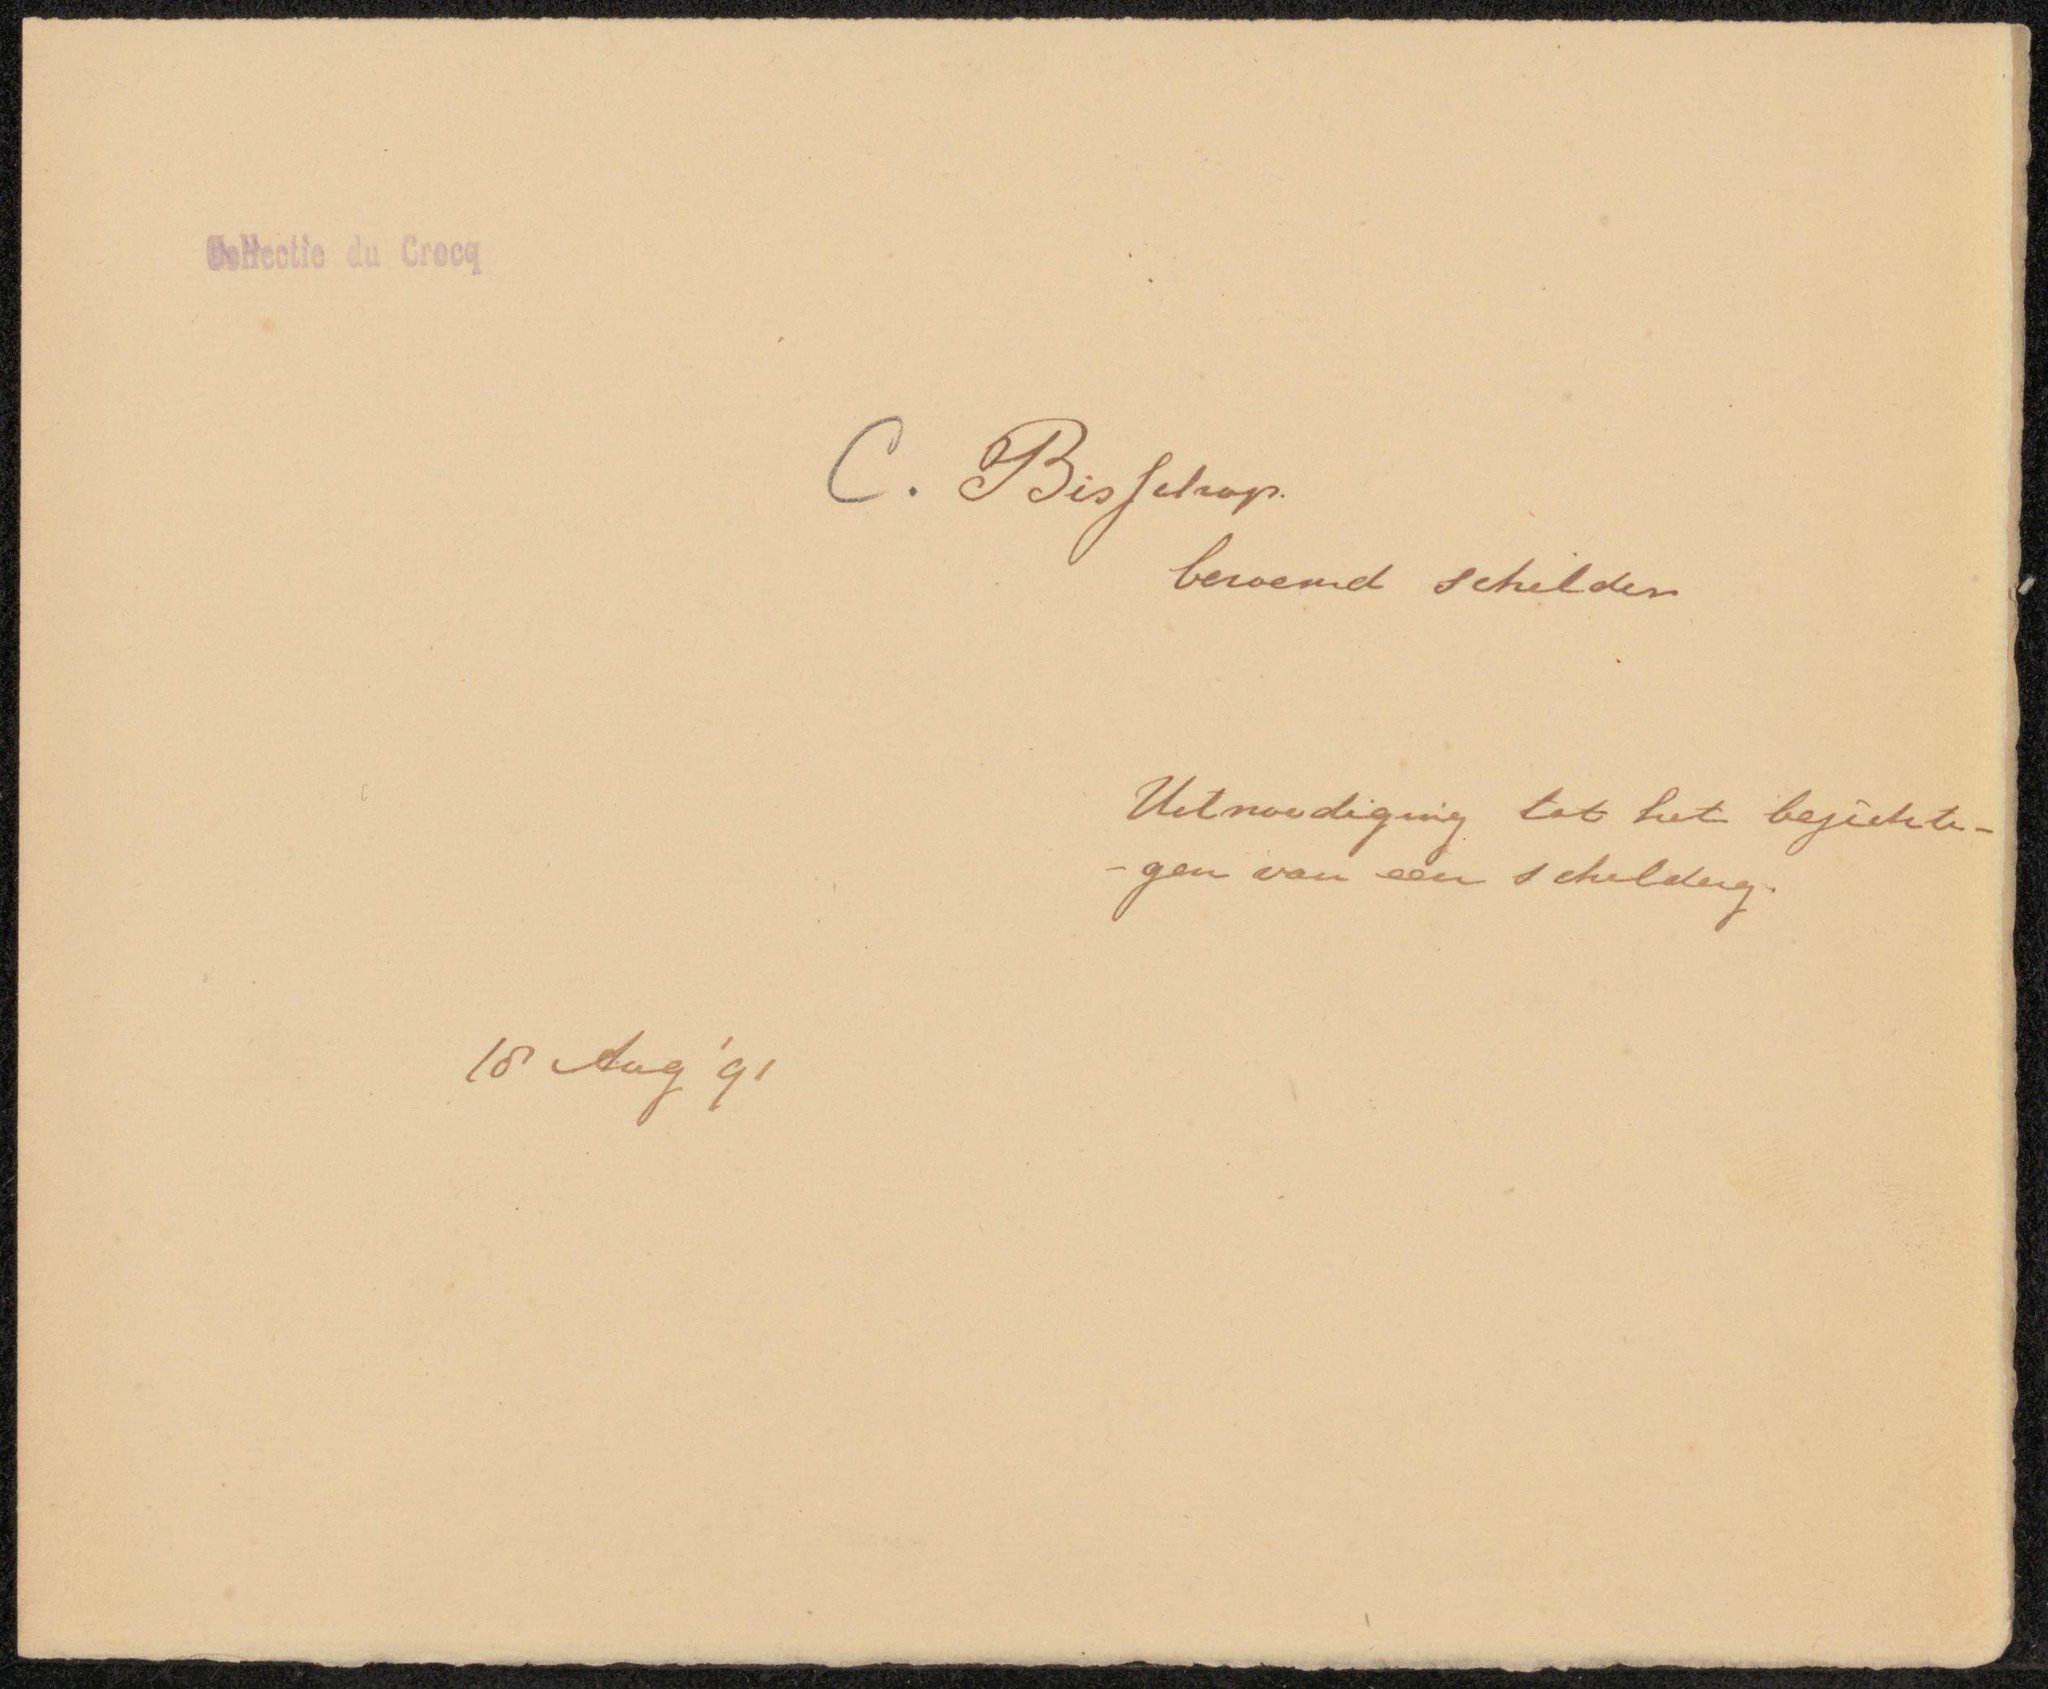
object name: invitation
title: Uitnodiging tot het bezichtigen van een schilderij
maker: Anonymous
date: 1891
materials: ink, paper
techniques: pen, writing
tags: print maker, draughtsman, christoffel bisschop, painting (including book-illumination, miniature-painting), exhibition ~ art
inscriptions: collector's mark: ‘RPK’, name: ‘Collectie du Crocq’